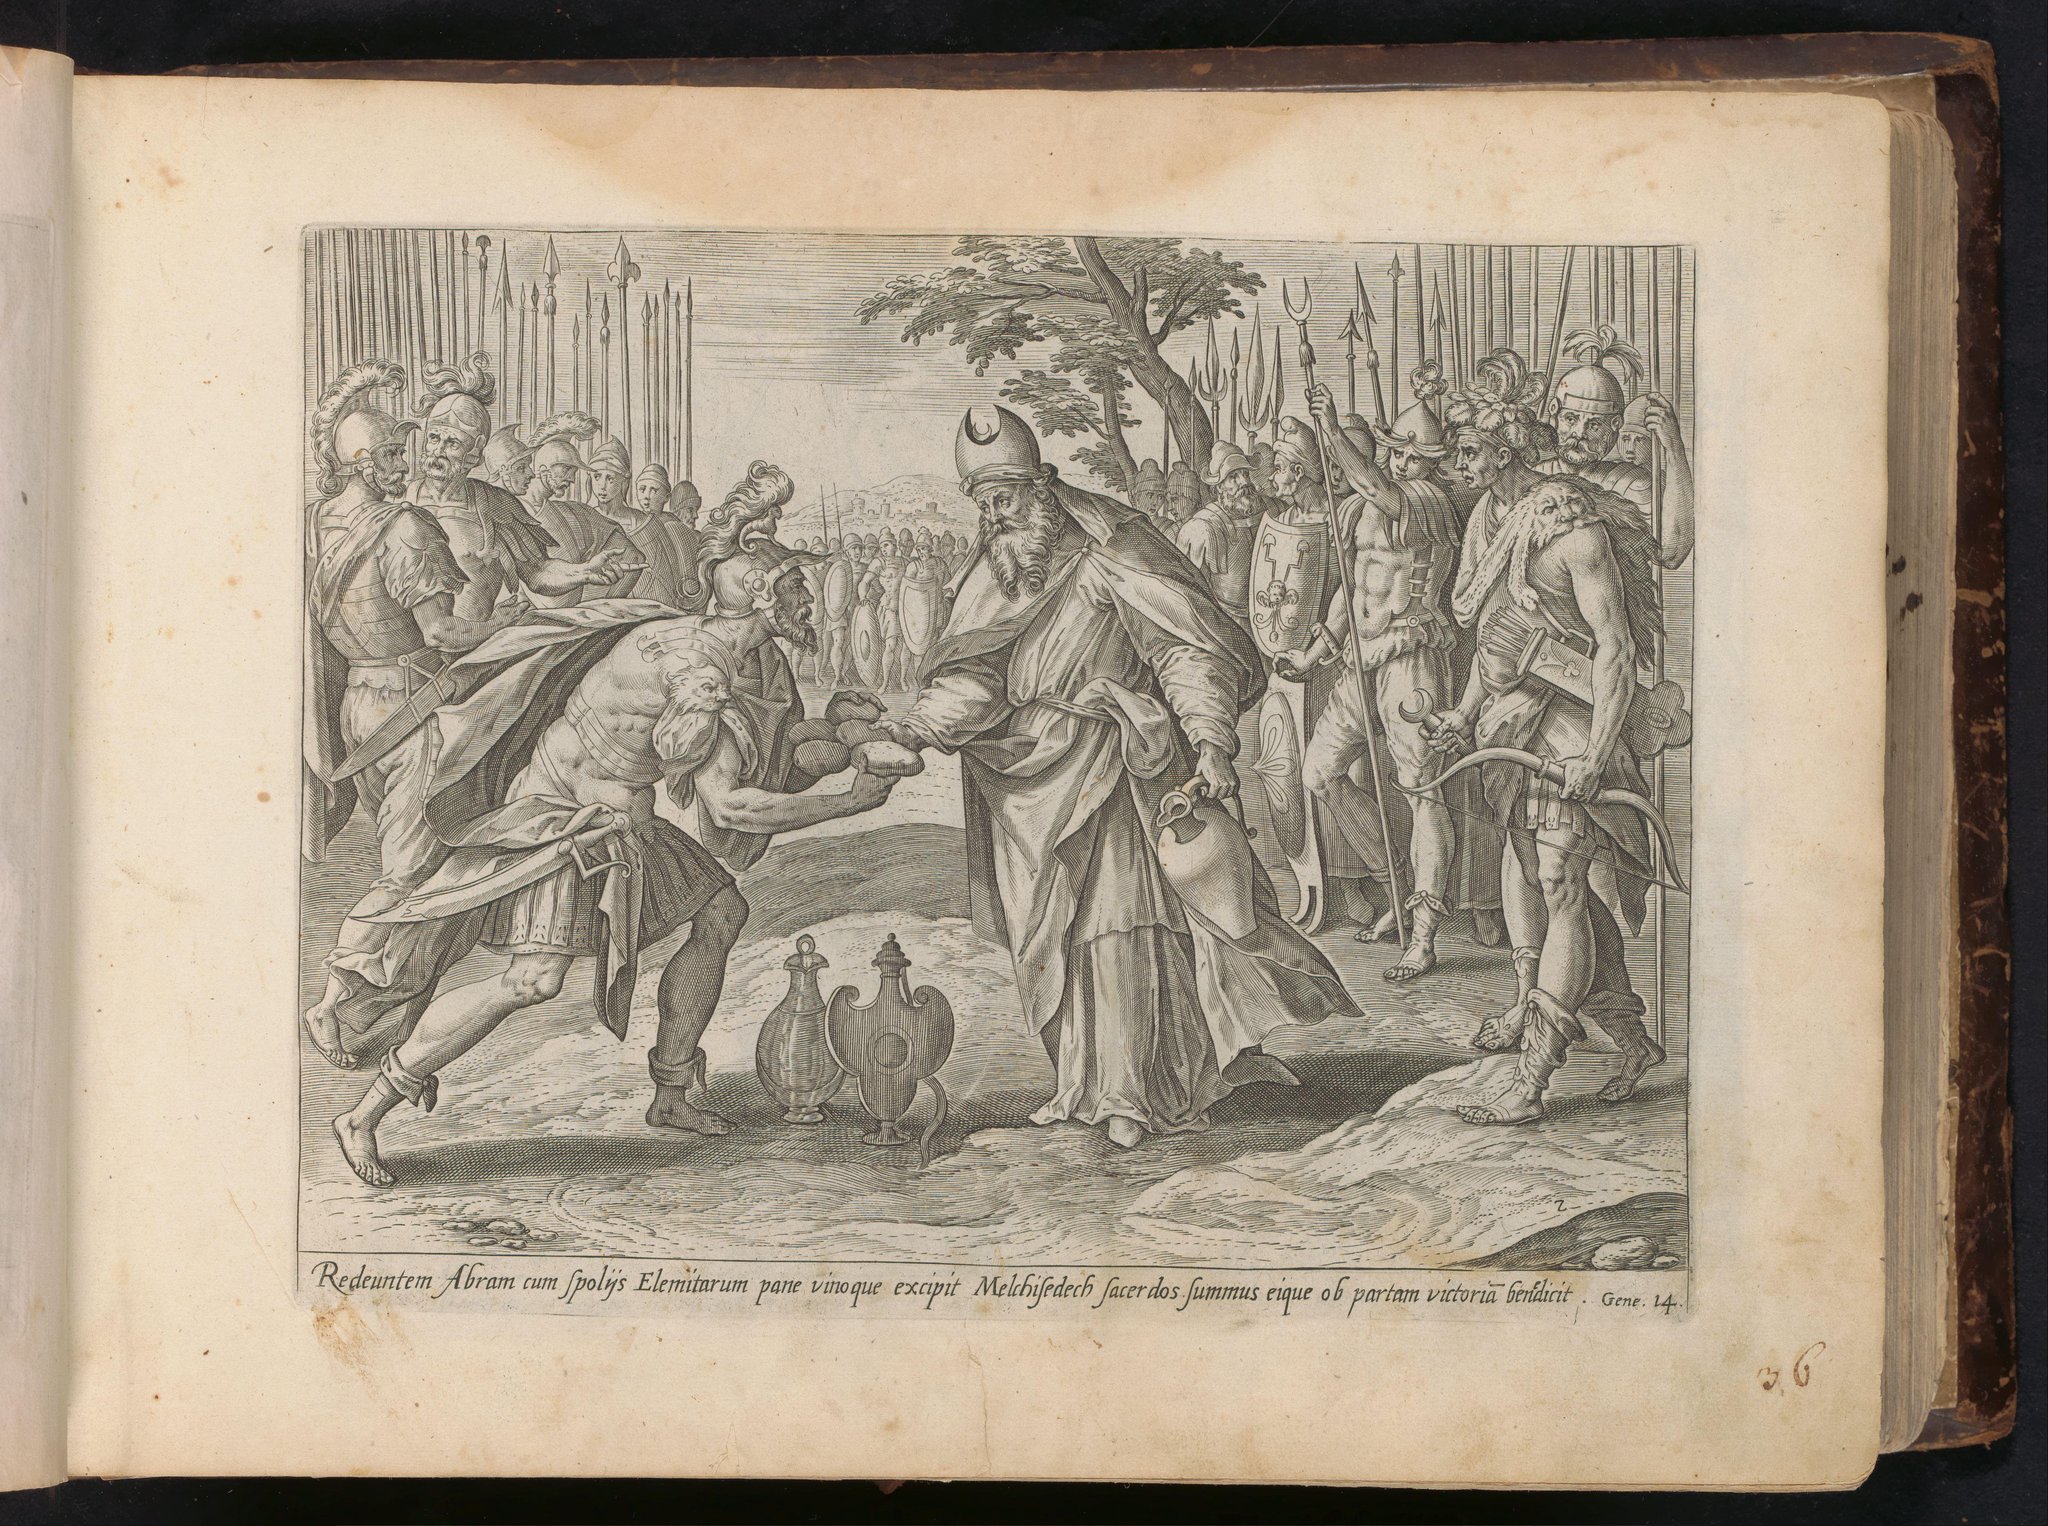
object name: album leaf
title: Den Grooten Figuer-Bibel (...)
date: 1585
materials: paper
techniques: engraving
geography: antwerp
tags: the meeting of abraham and melchizedek, the high priest and king of salem, who brings bread and wine (genesis 14:18-20)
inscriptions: number: ‘36’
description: Melchisedek, de hogepriester en koning van Salem (Jeruzalem), geeft Abraham brood en een kan met wijn. Abraham, gekleed in harnas en met helm op het hoofd, neemt het brood aan, terwijl achter hem zijn soldaten staan. Achter Melchisedek staat zijn leger. Onder de voorstelling een verwijzing in het Latijn naar de Bijbeltekst in Gen. 14. Deze prent maakt deel uit van een album.